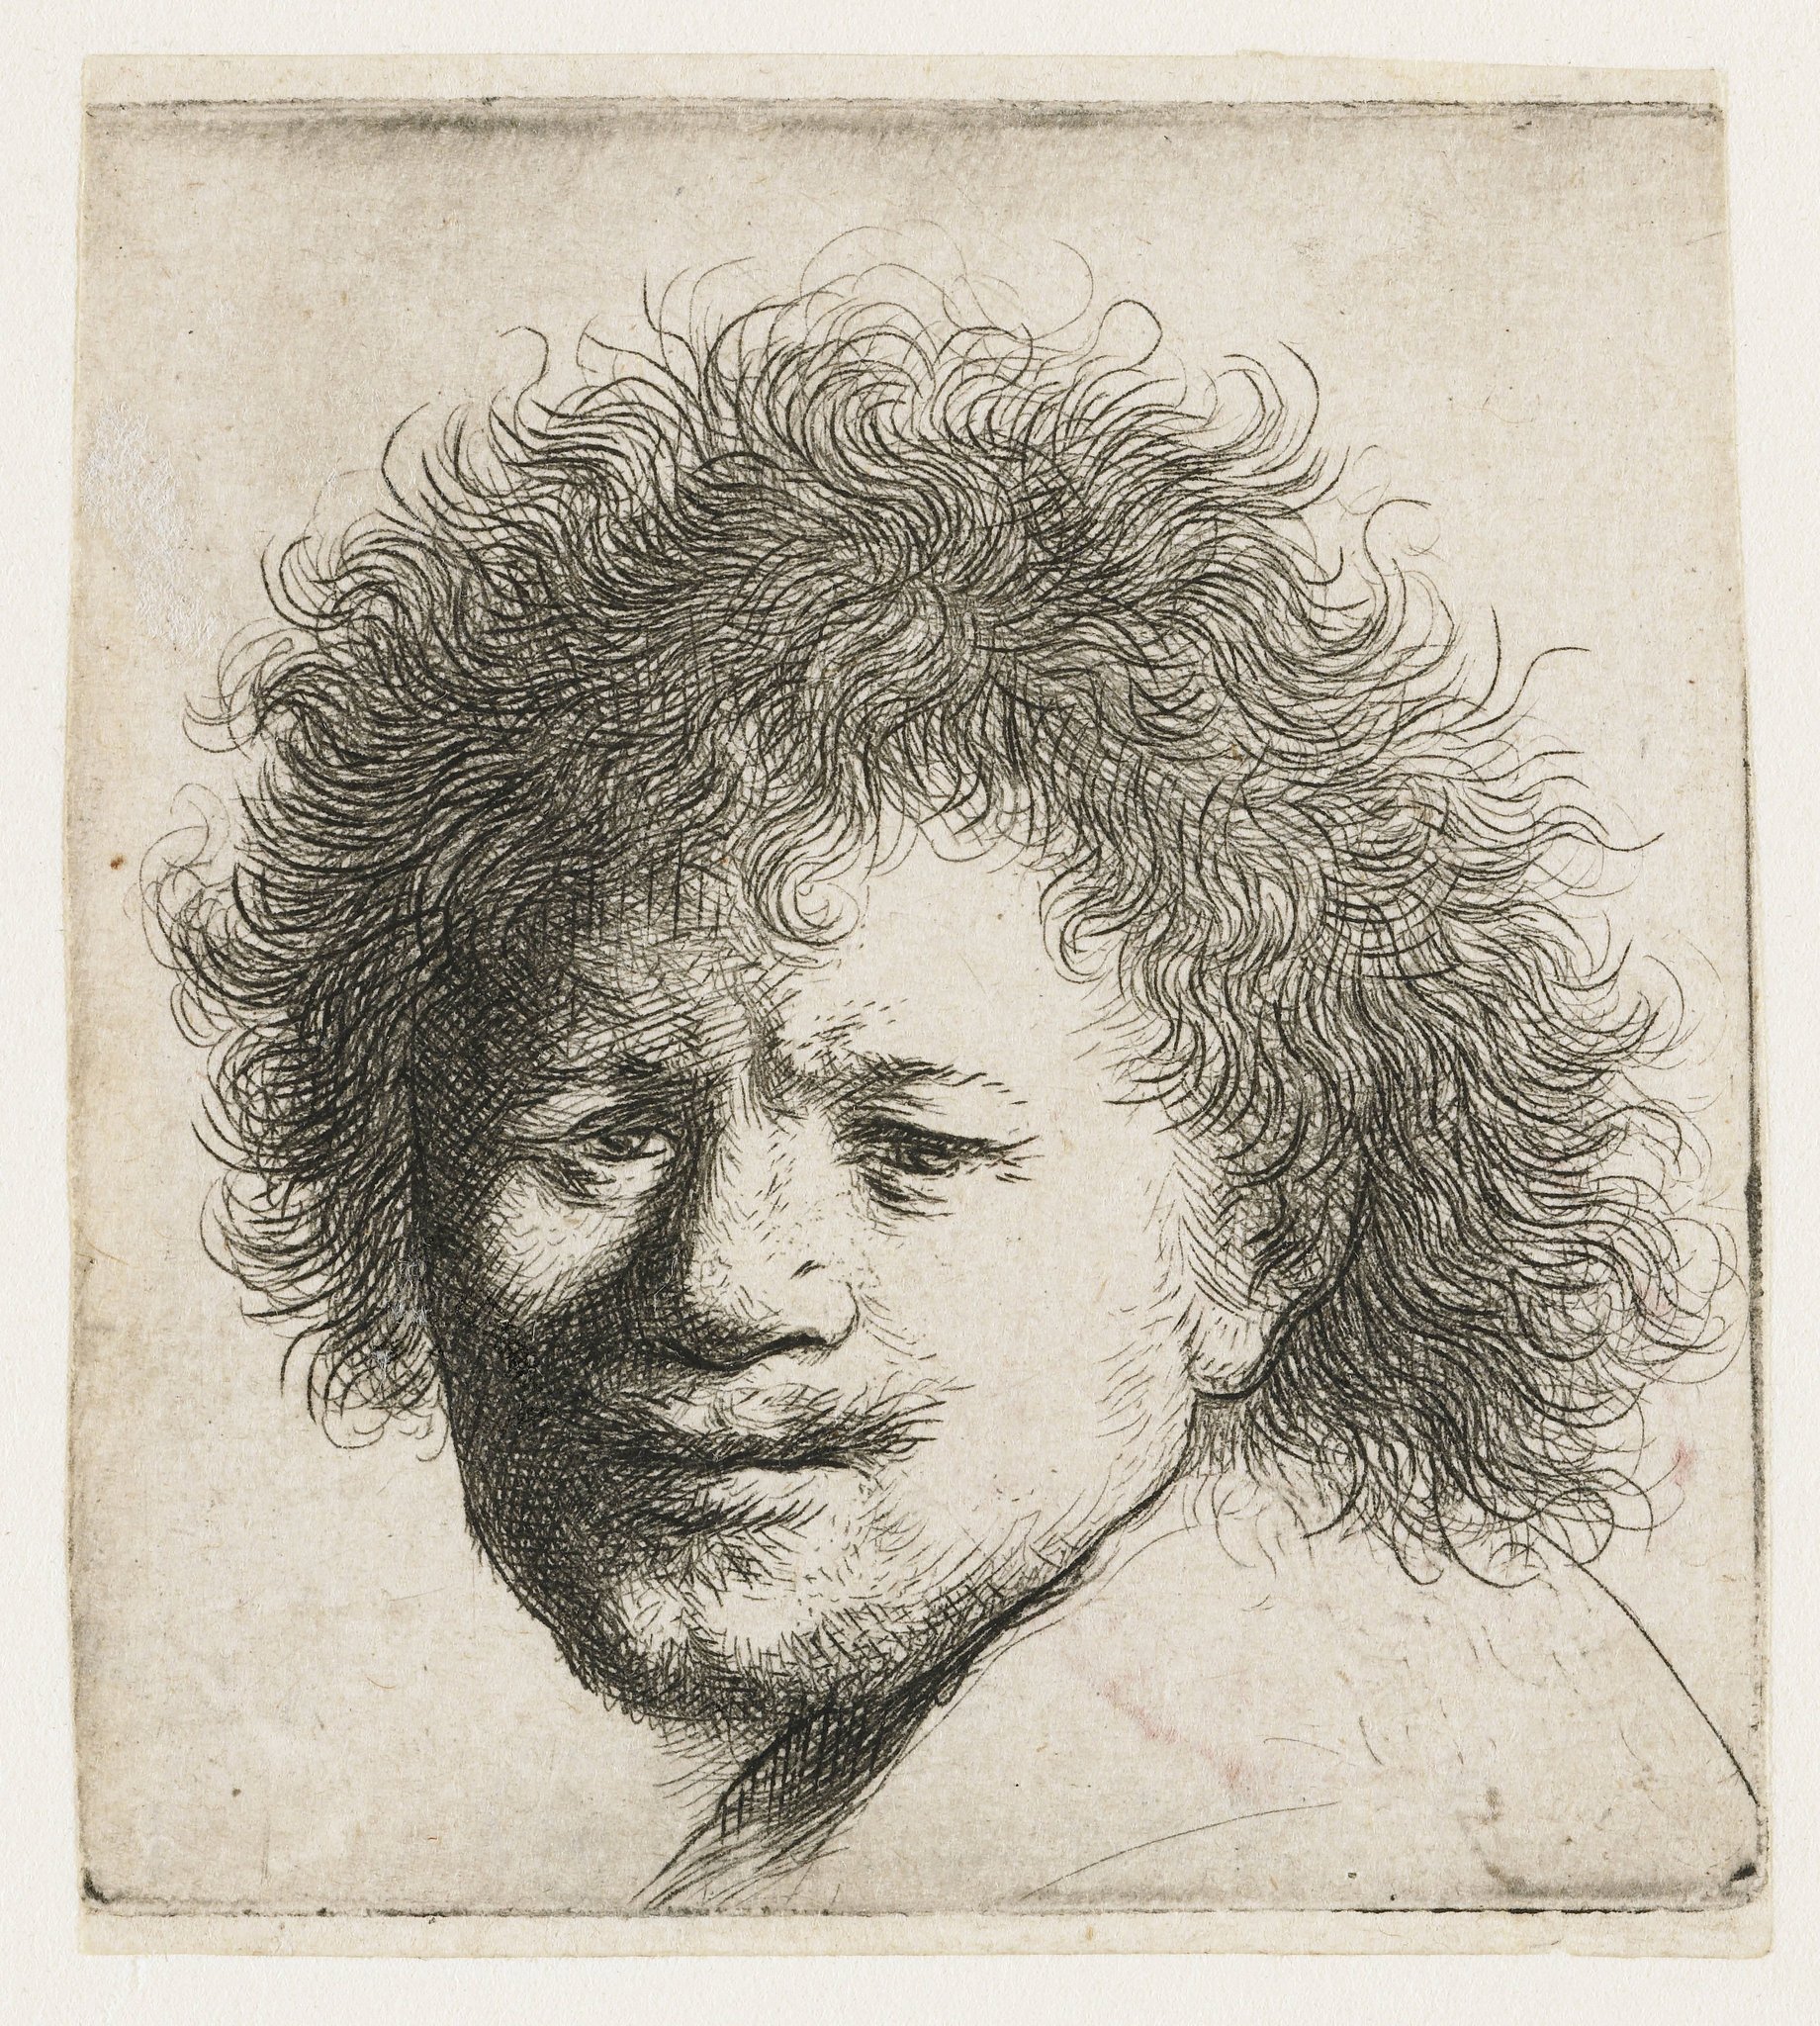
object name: print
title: Self-portrait with long bushy hair: head only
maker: rembrandt van rijn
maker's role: draughtsman, painter, print maker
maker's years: 1606-1669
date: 1631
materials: paper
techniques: etching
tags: leiden, amsterdam, painter, print maker, draughtsman, rembrandt van rijn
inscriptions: collector's mark: Lugt 240